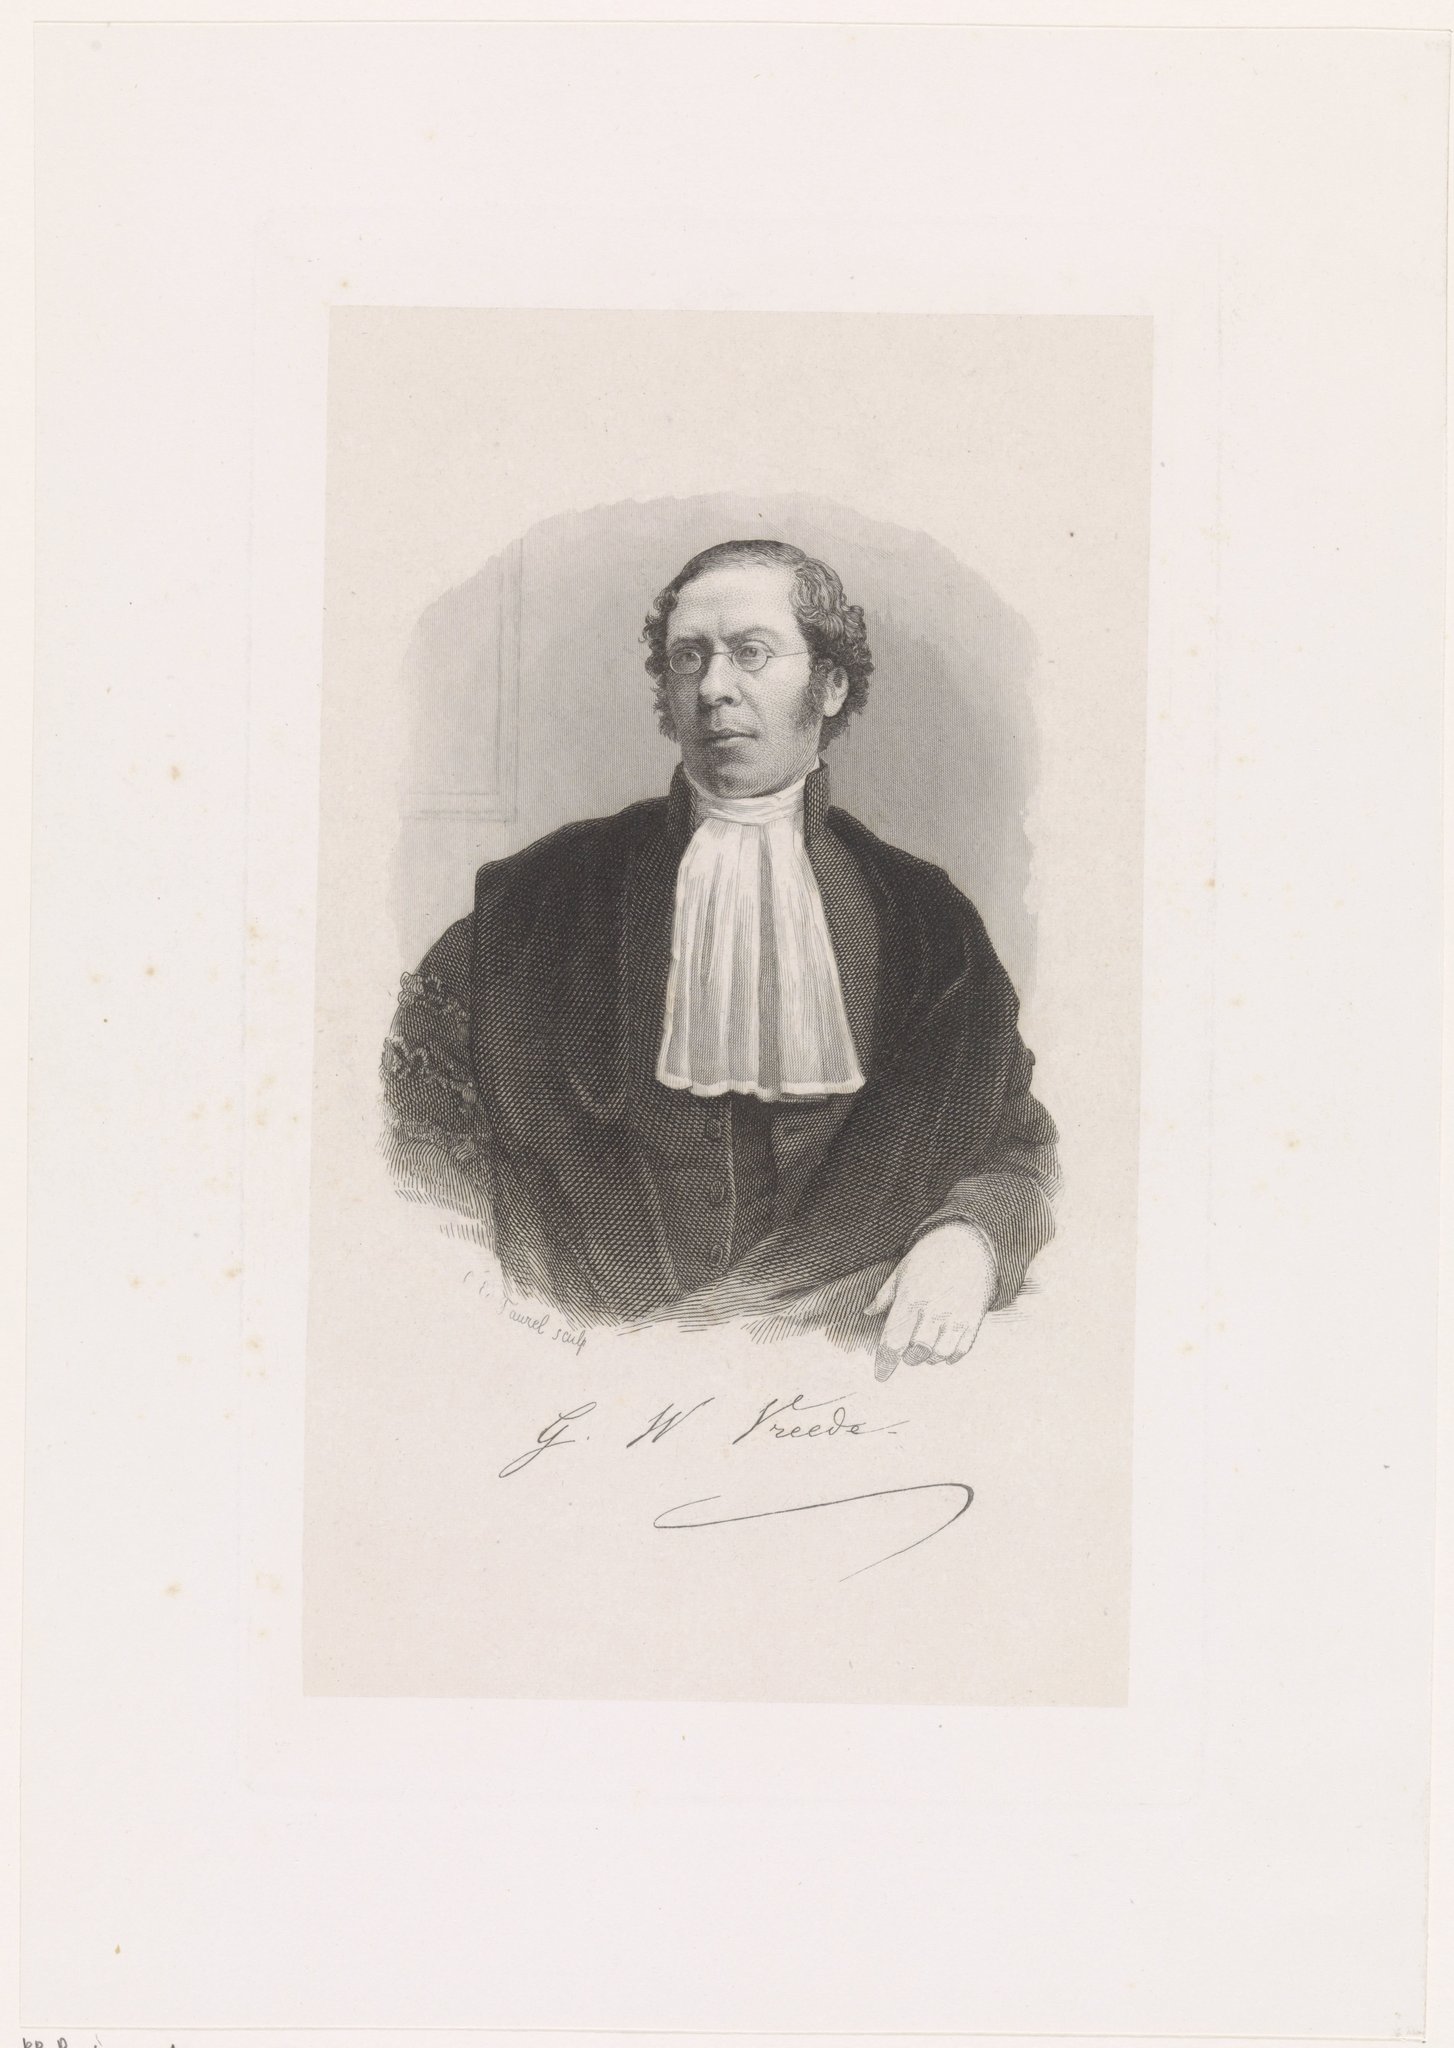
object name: print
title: Portret van de Utrechtse hoogleraar George Willem Vreede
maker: edouard taurel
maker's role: draughtsman, print maker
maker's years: 1824-1892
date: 1861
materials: paper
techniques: engraving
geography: amsterdam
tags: utrecht, george willem vreede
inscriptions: collector's mark: Lugt 2228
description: Prent ook gebruikt in: Utrechtsche Studenten Almanak, 1861.